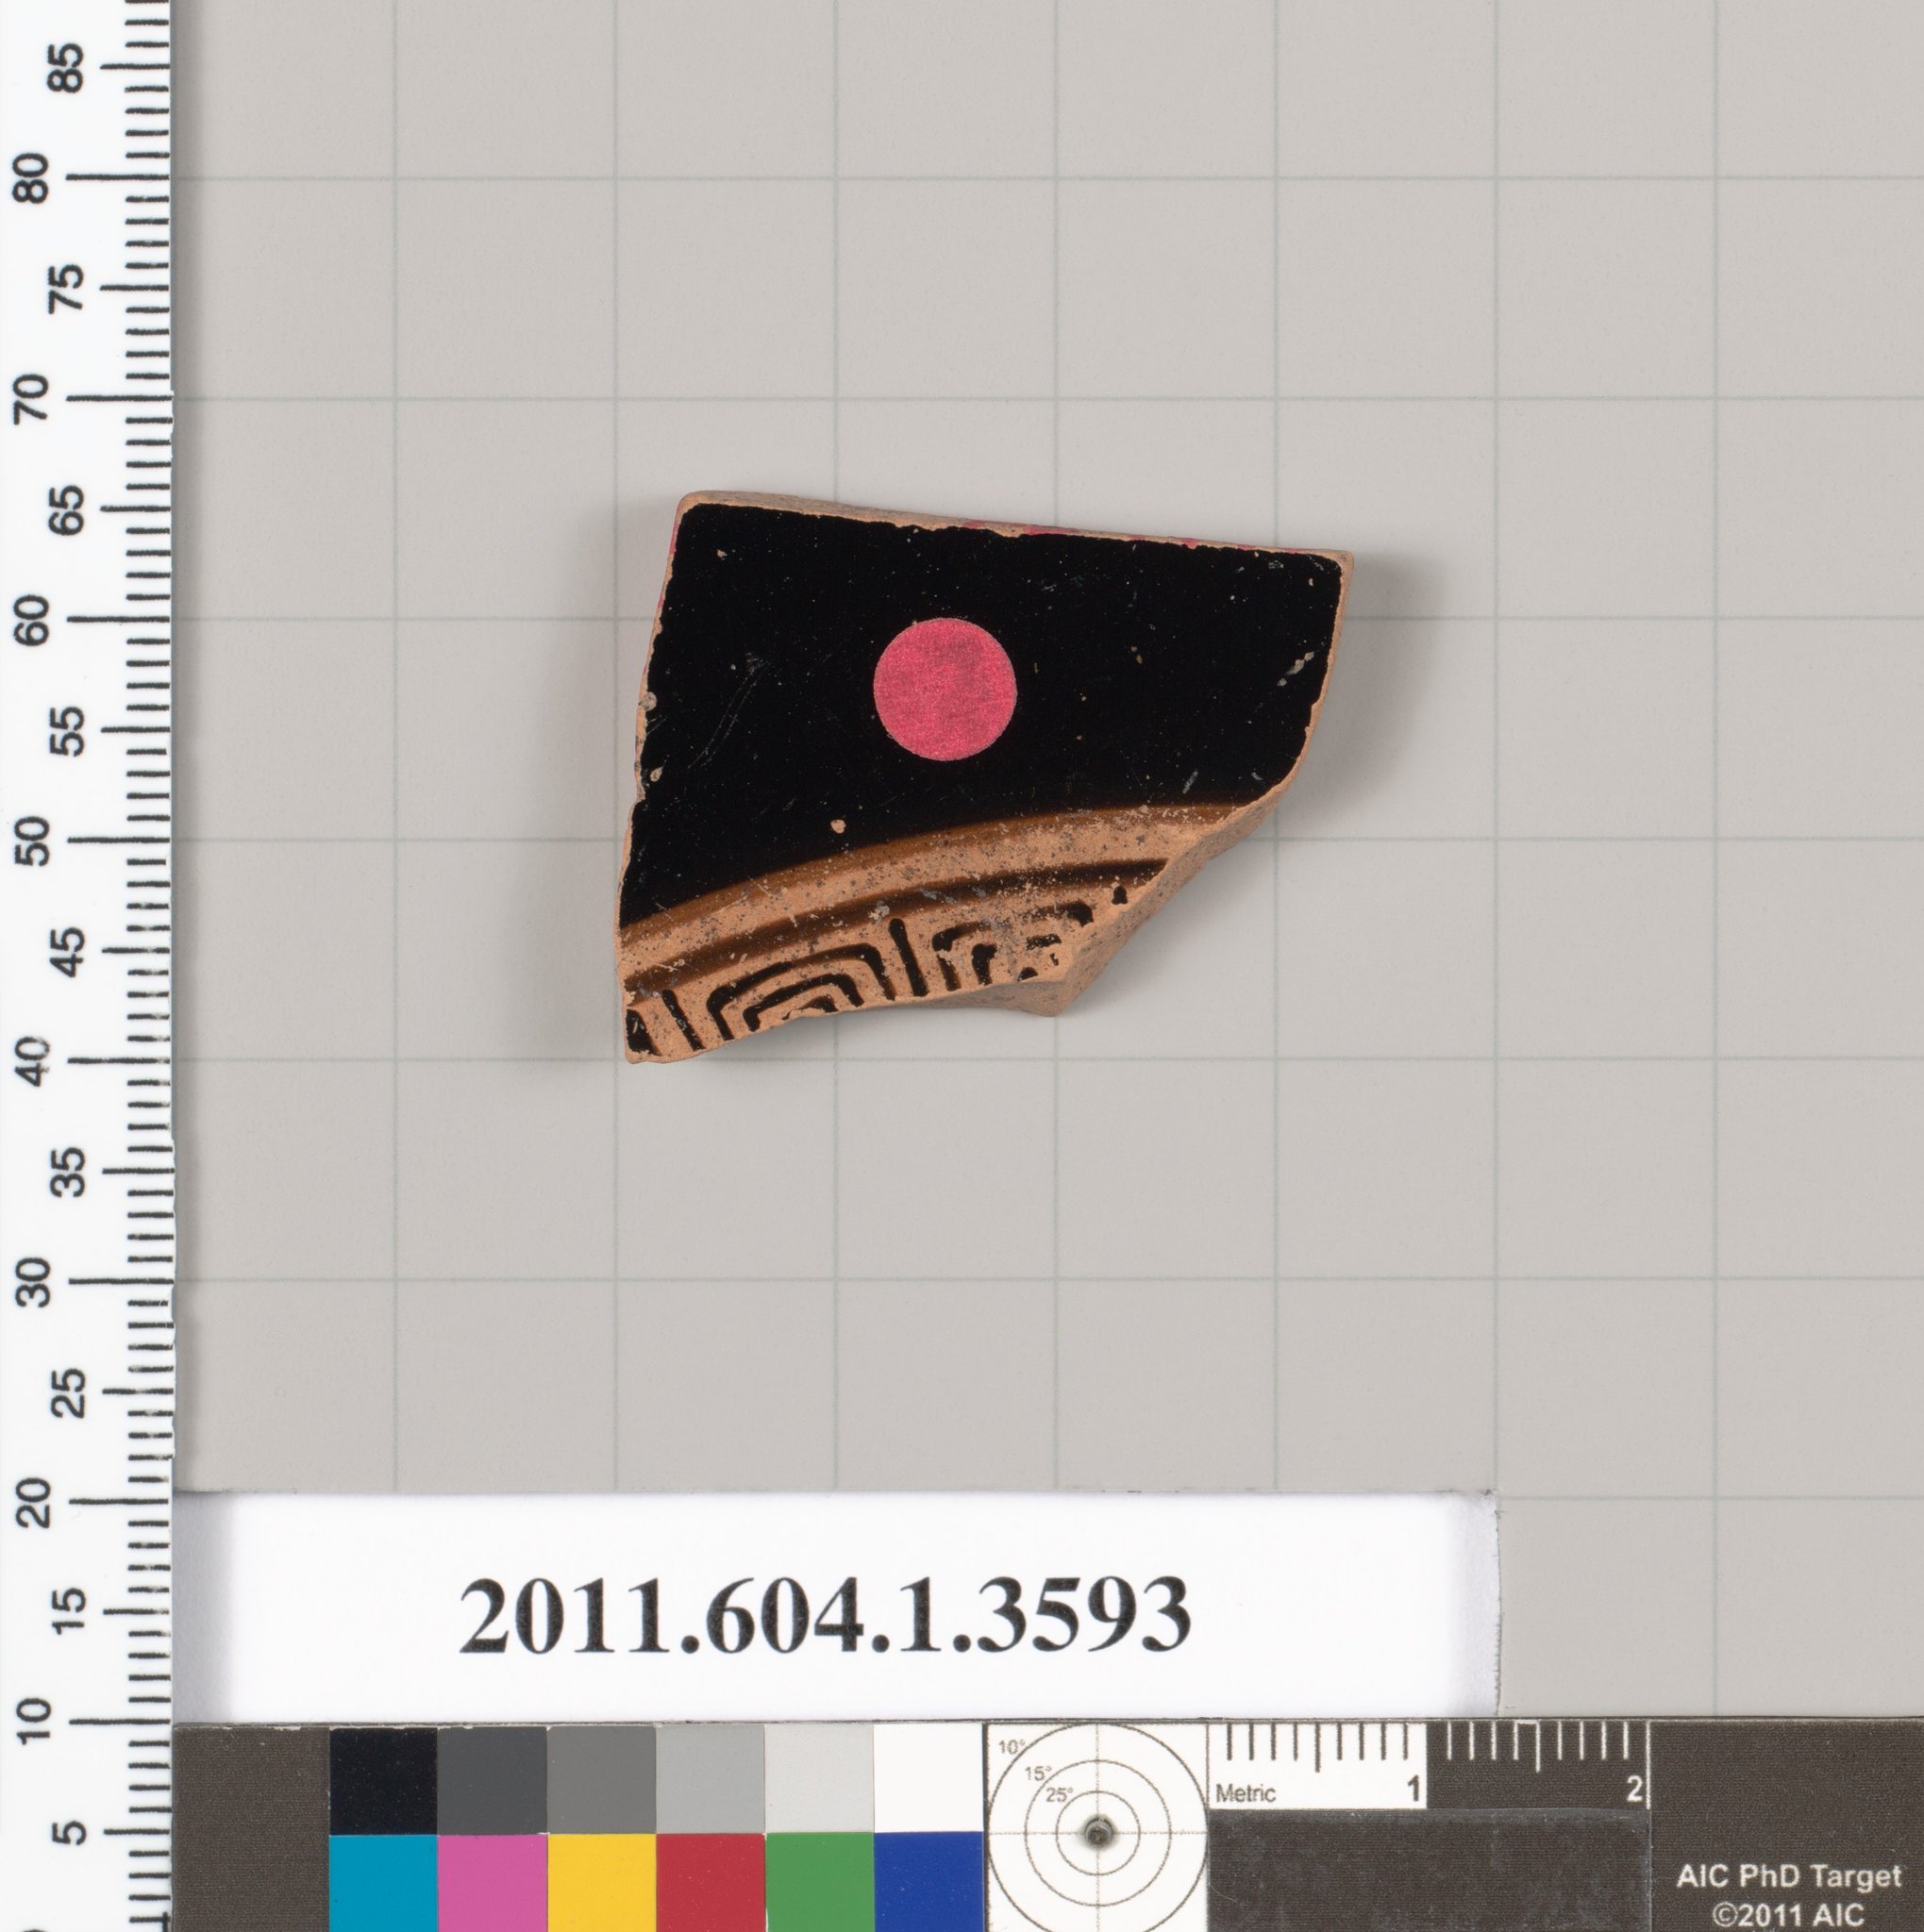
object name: kylix fragment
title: Terracotta fragment of a kylix (drinking cup)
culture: greek, attic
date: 480-470 BCE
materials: terracotta